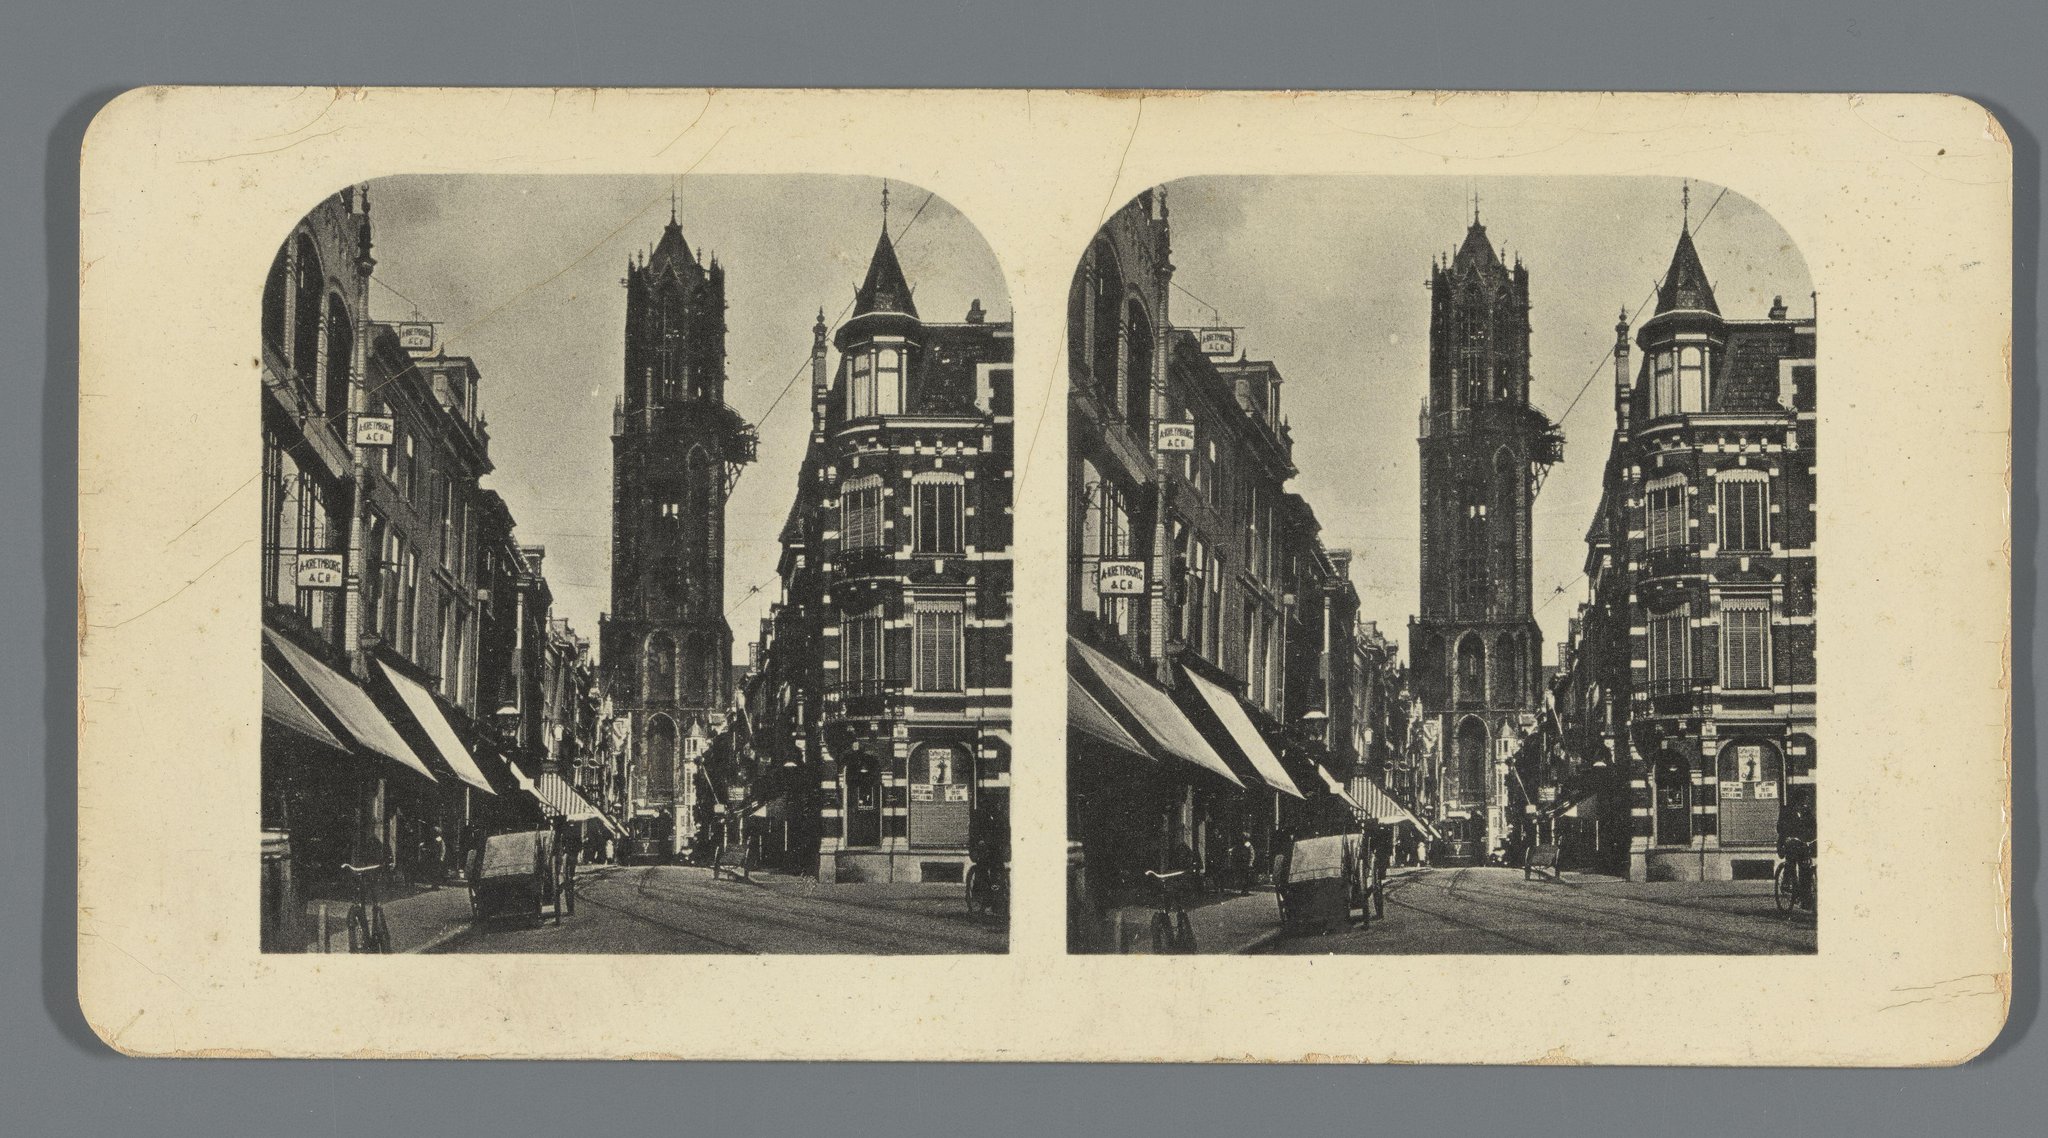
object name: photomechanical print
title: Gezicht op de Zadelstraat en de Dom in Utrecht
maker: Anonymous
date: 1875-1900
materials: paper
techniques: photograph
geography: utrecht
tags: street, parts of church exterior and annexes: tower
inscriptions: number: ‘23.’